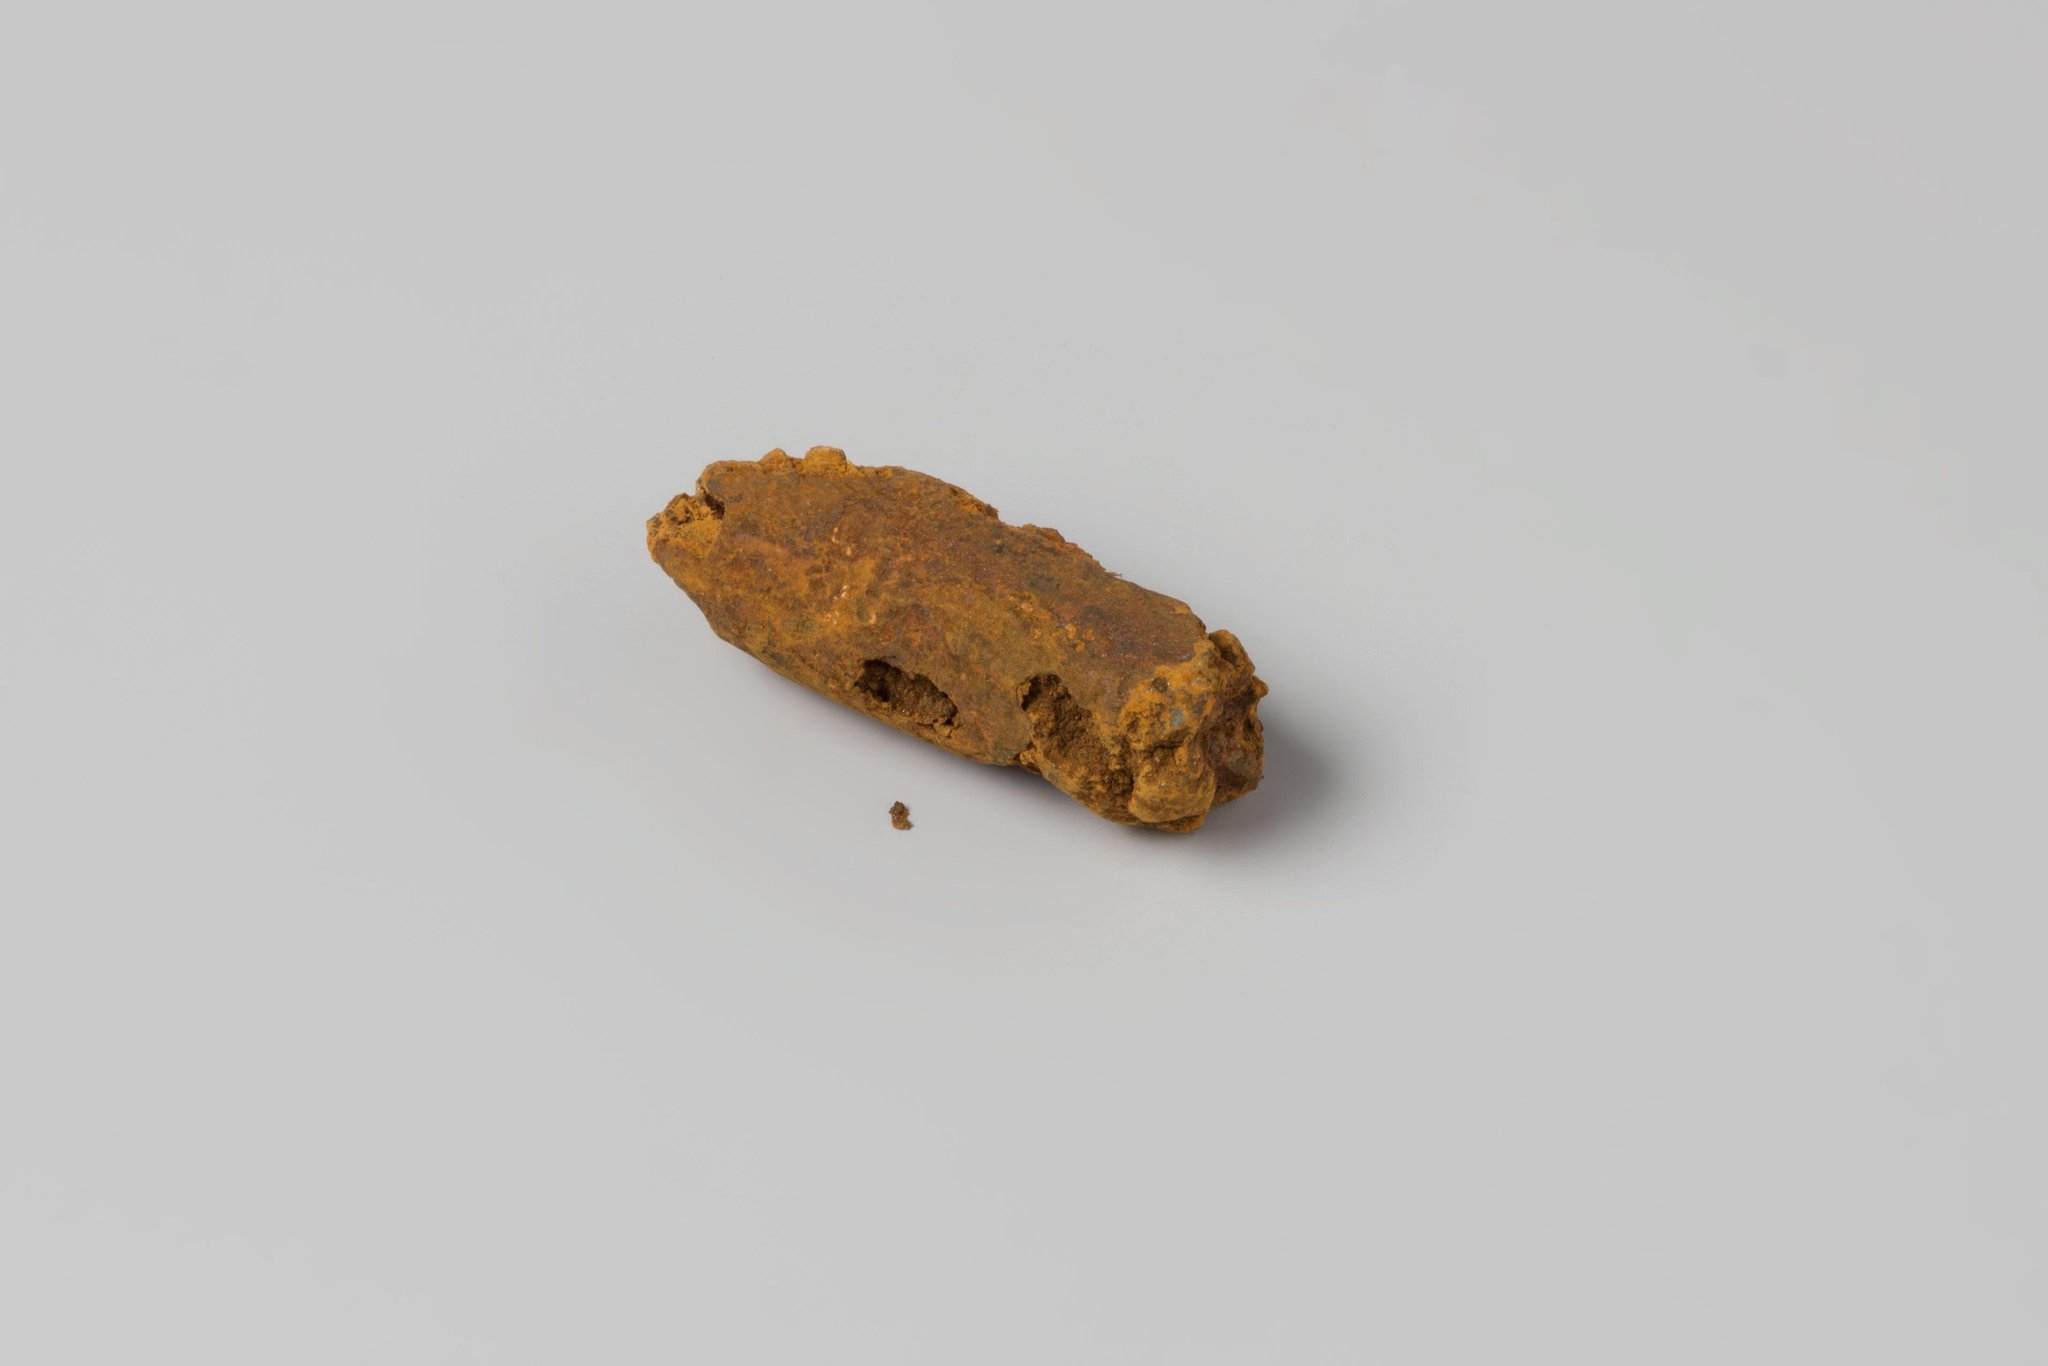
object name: concretionary stone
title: Concretie van vulling van patroonbuis uit het wrak van de Oost-Indiëvaarder Hollandia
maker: Anonymous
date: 1700-1743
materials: stone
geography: netherlands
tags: verenigde oostindische compagnie, hollandia (schip), annet